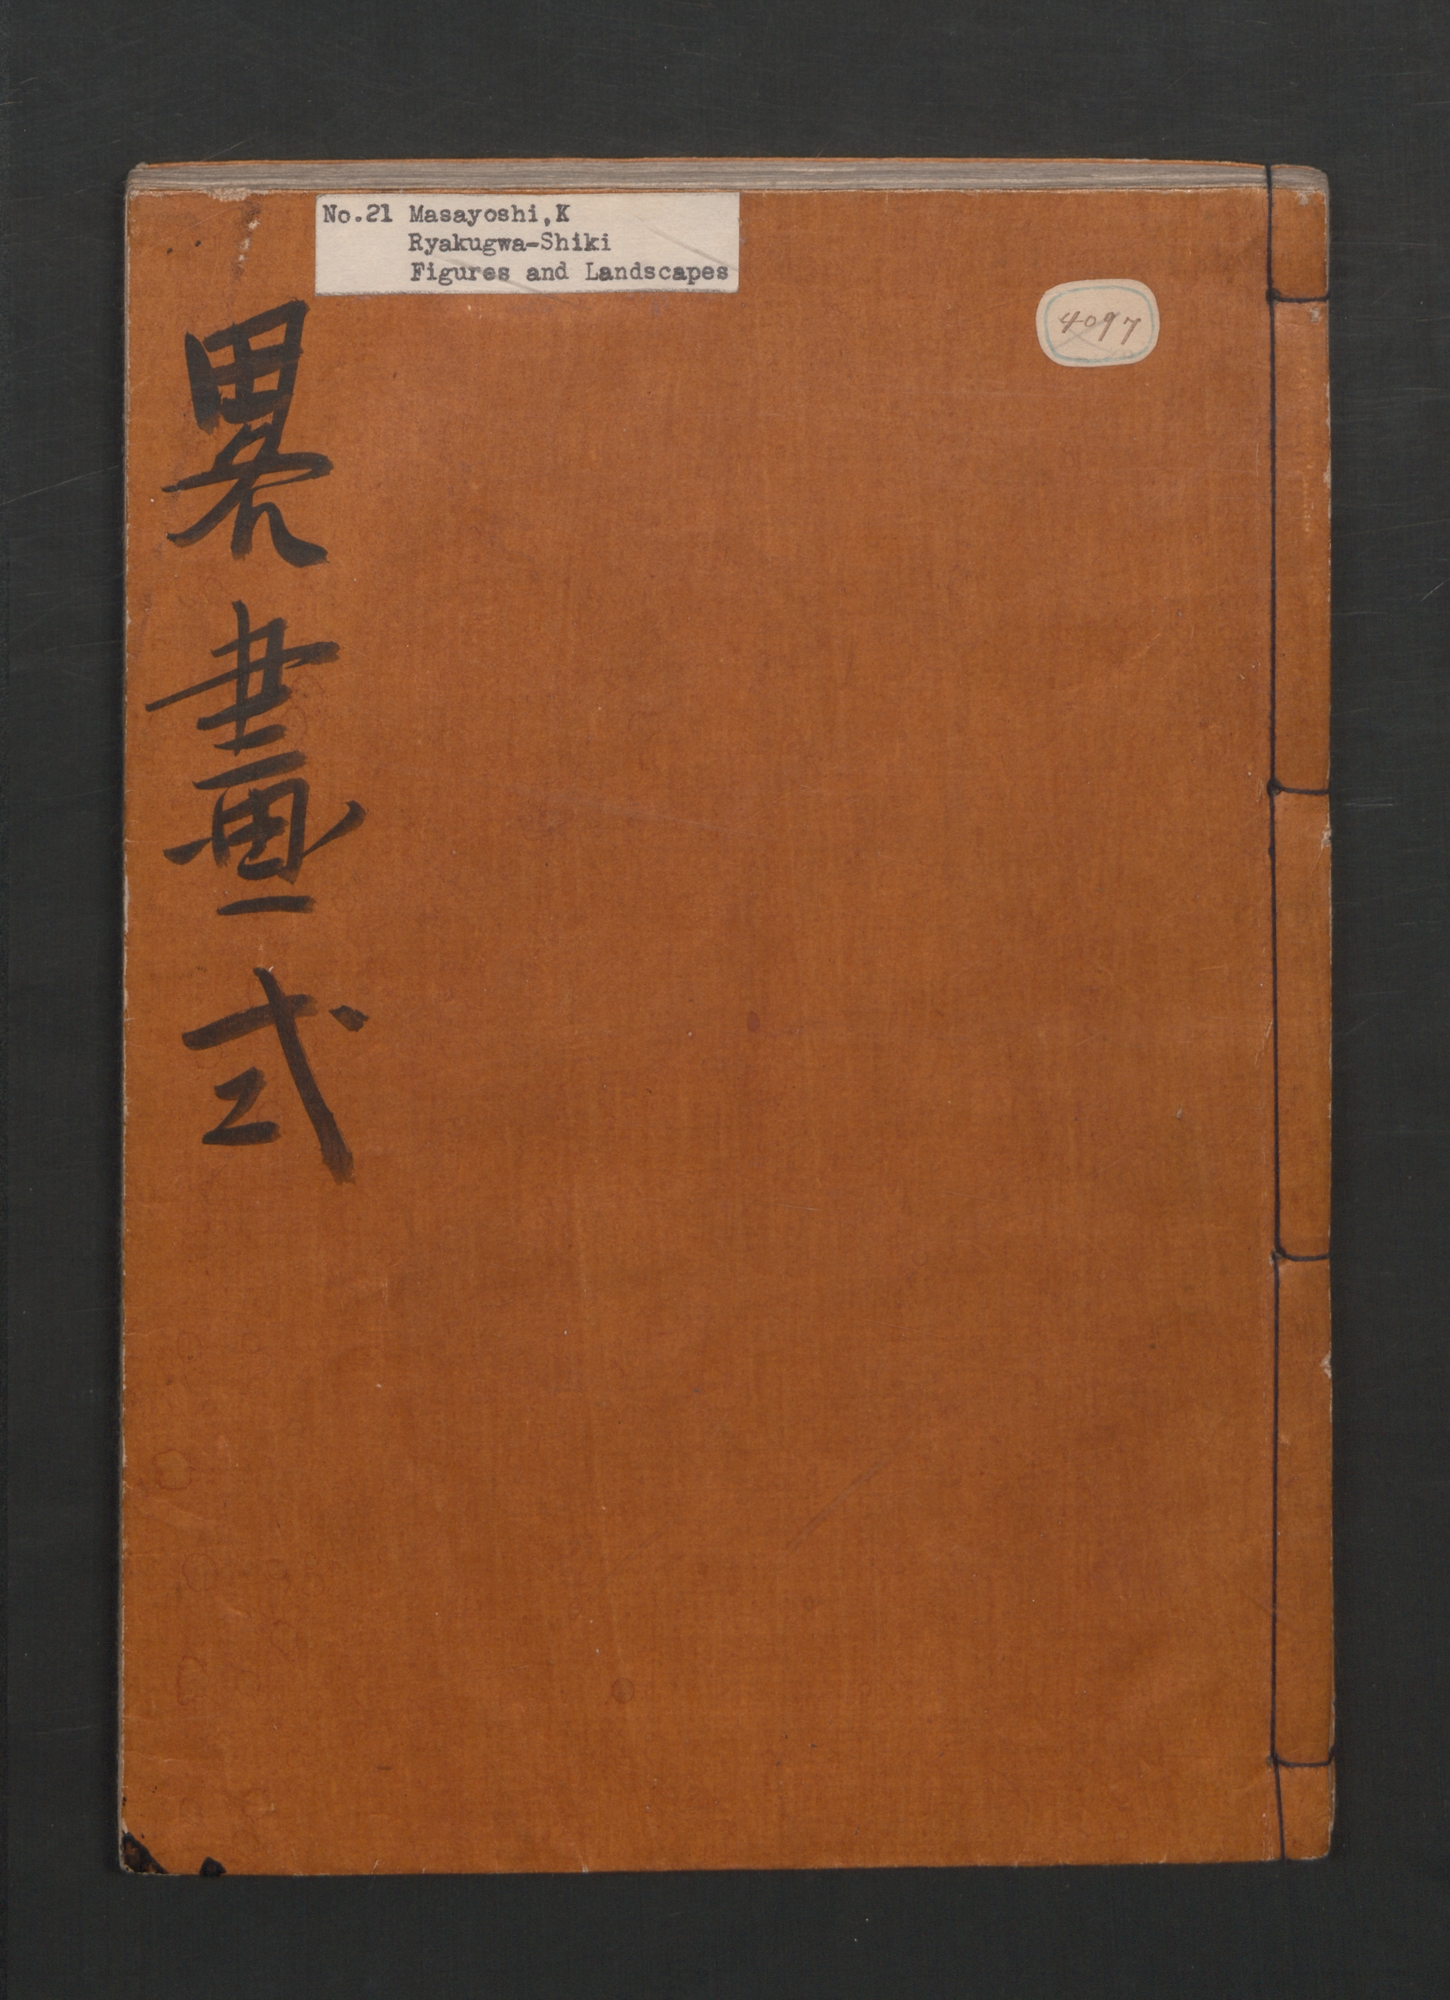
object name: illustrated book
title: Abbreviated Drawing Styles (Figures) (Ryakuga shiki) 略画式 (人物)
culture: japanese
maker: kuwagata keisai 鍬形蕙斎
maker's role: artist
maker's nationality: japanese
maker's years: 1764-1824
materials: ink, paper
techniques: woodblock print